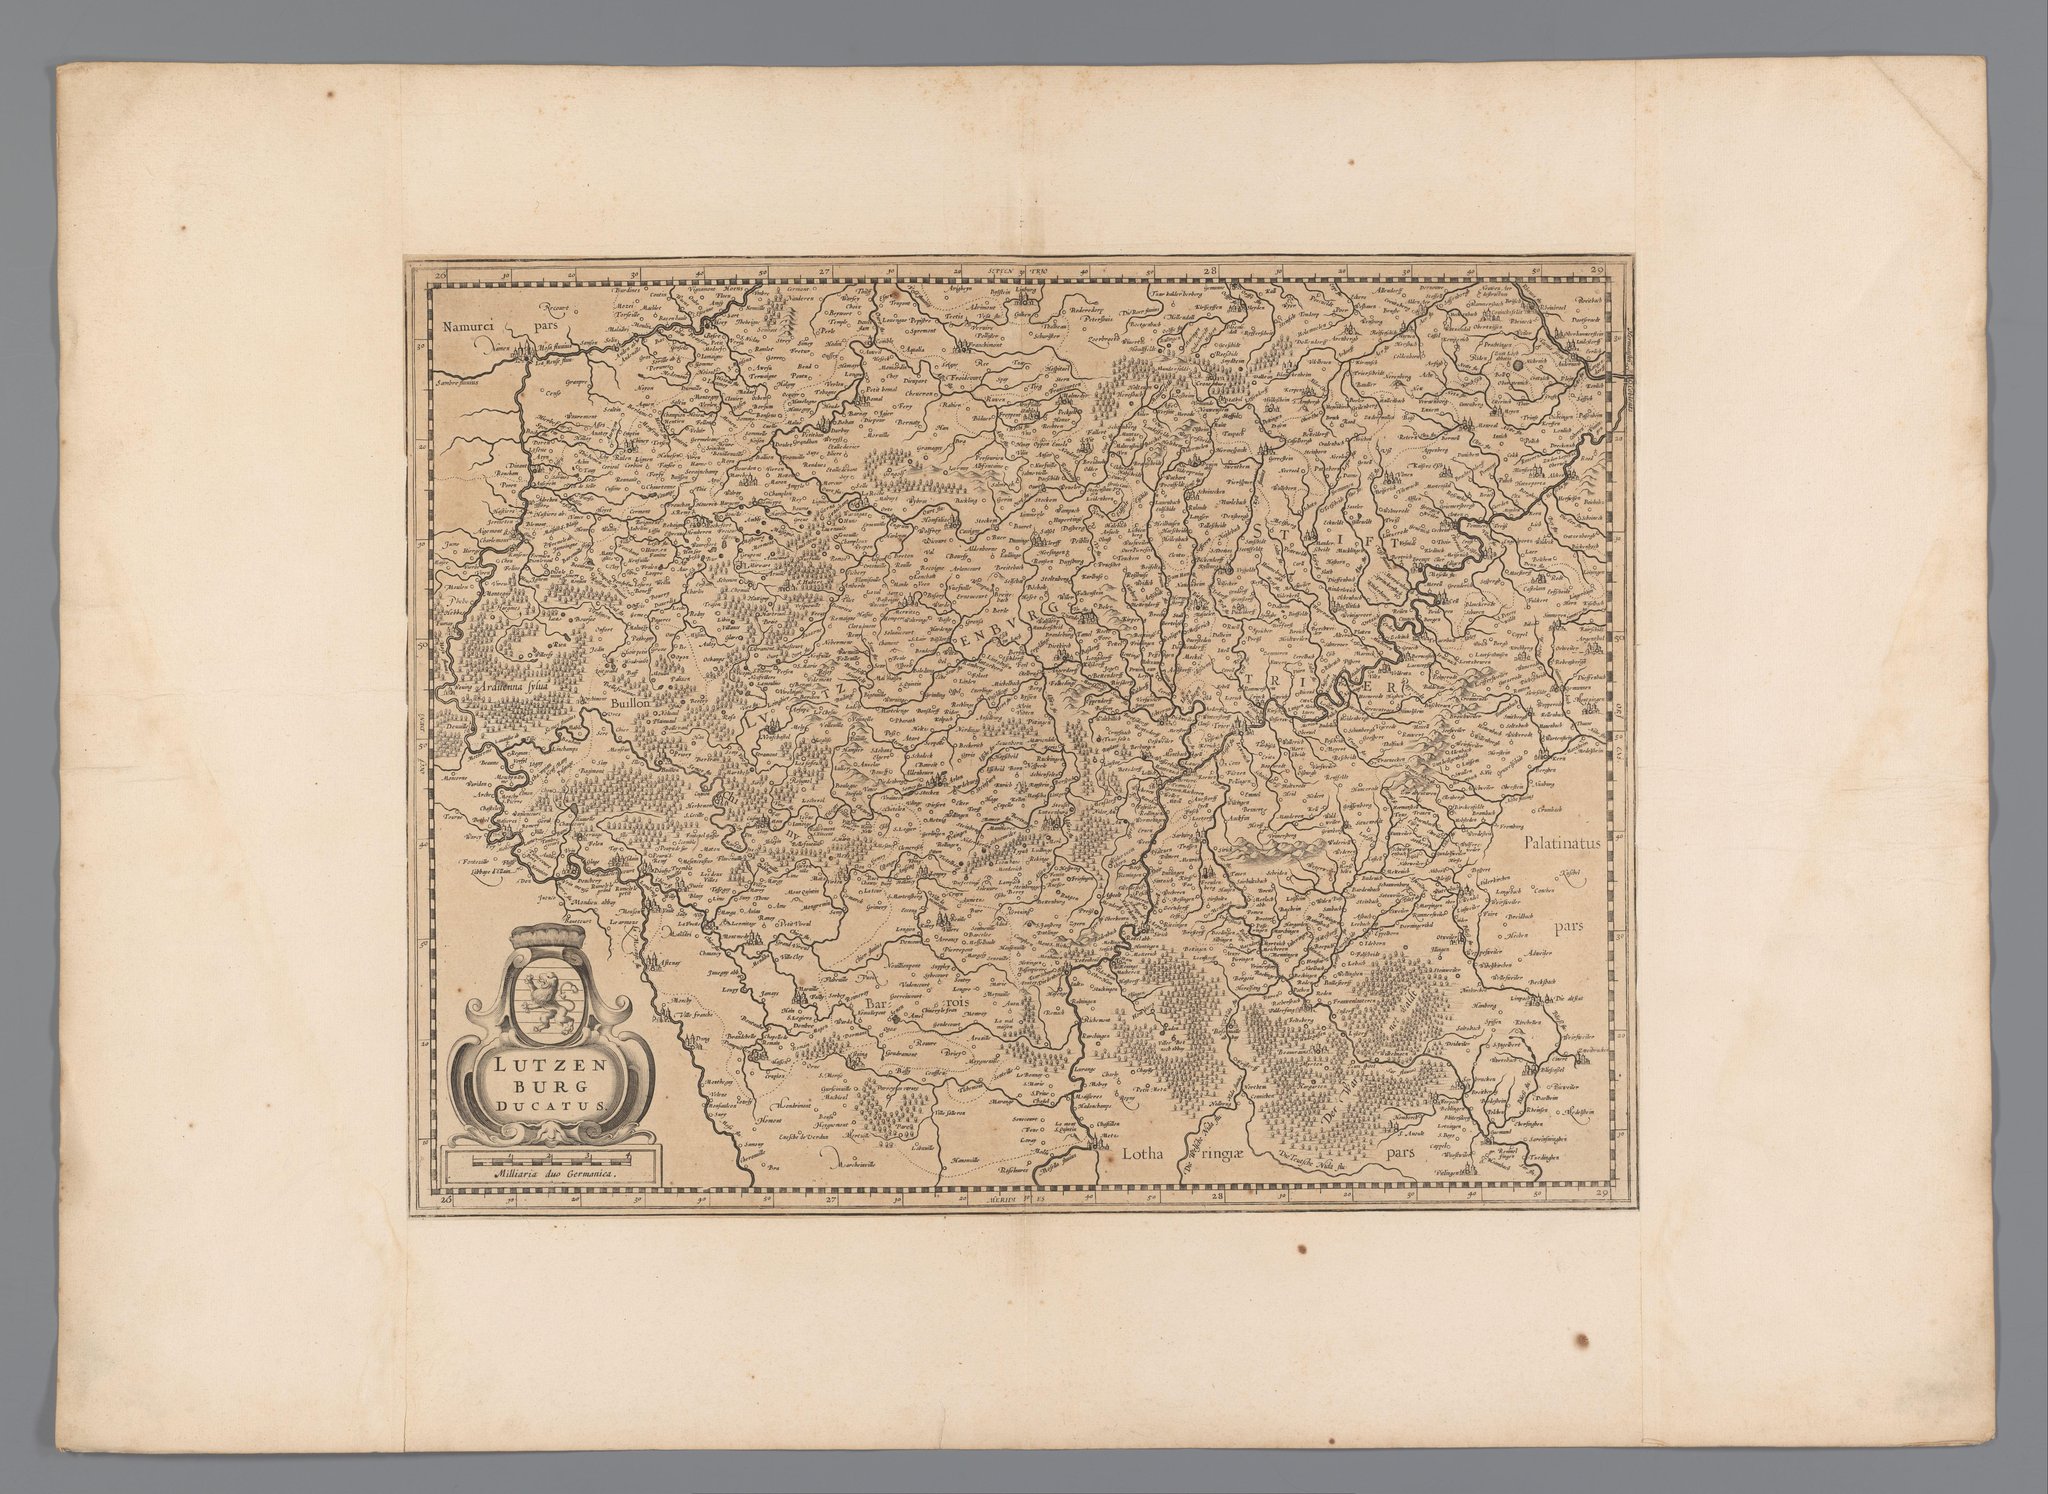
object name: map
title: Lutzenburg ducatus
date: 1638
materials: paper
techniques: etching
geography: amsterdam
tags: maps of separate countries or regions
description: Prent gebruikt in: Mercator, Gerard, en Jodocus Hondius. Atlas Novus sive descriptio Geographica totius Orbis Terrarum, Tabulis Aeneis Luculentissimis & Accuratissimis Exornata, Tribus Tomis Distinctus. Amsterdam: Henricus Hondius, 1638. Of: Mercator, Gerard, en Jodocus Hondius. Atlas Novus sive descriptio Geographica totius Orbis Terrarum, Tabulis Aeneis Luculentissimis & Accuratissimis Exornata, Tribus Tomis Distinctus. Amsterdam: Johannes Janssonius, 1638.